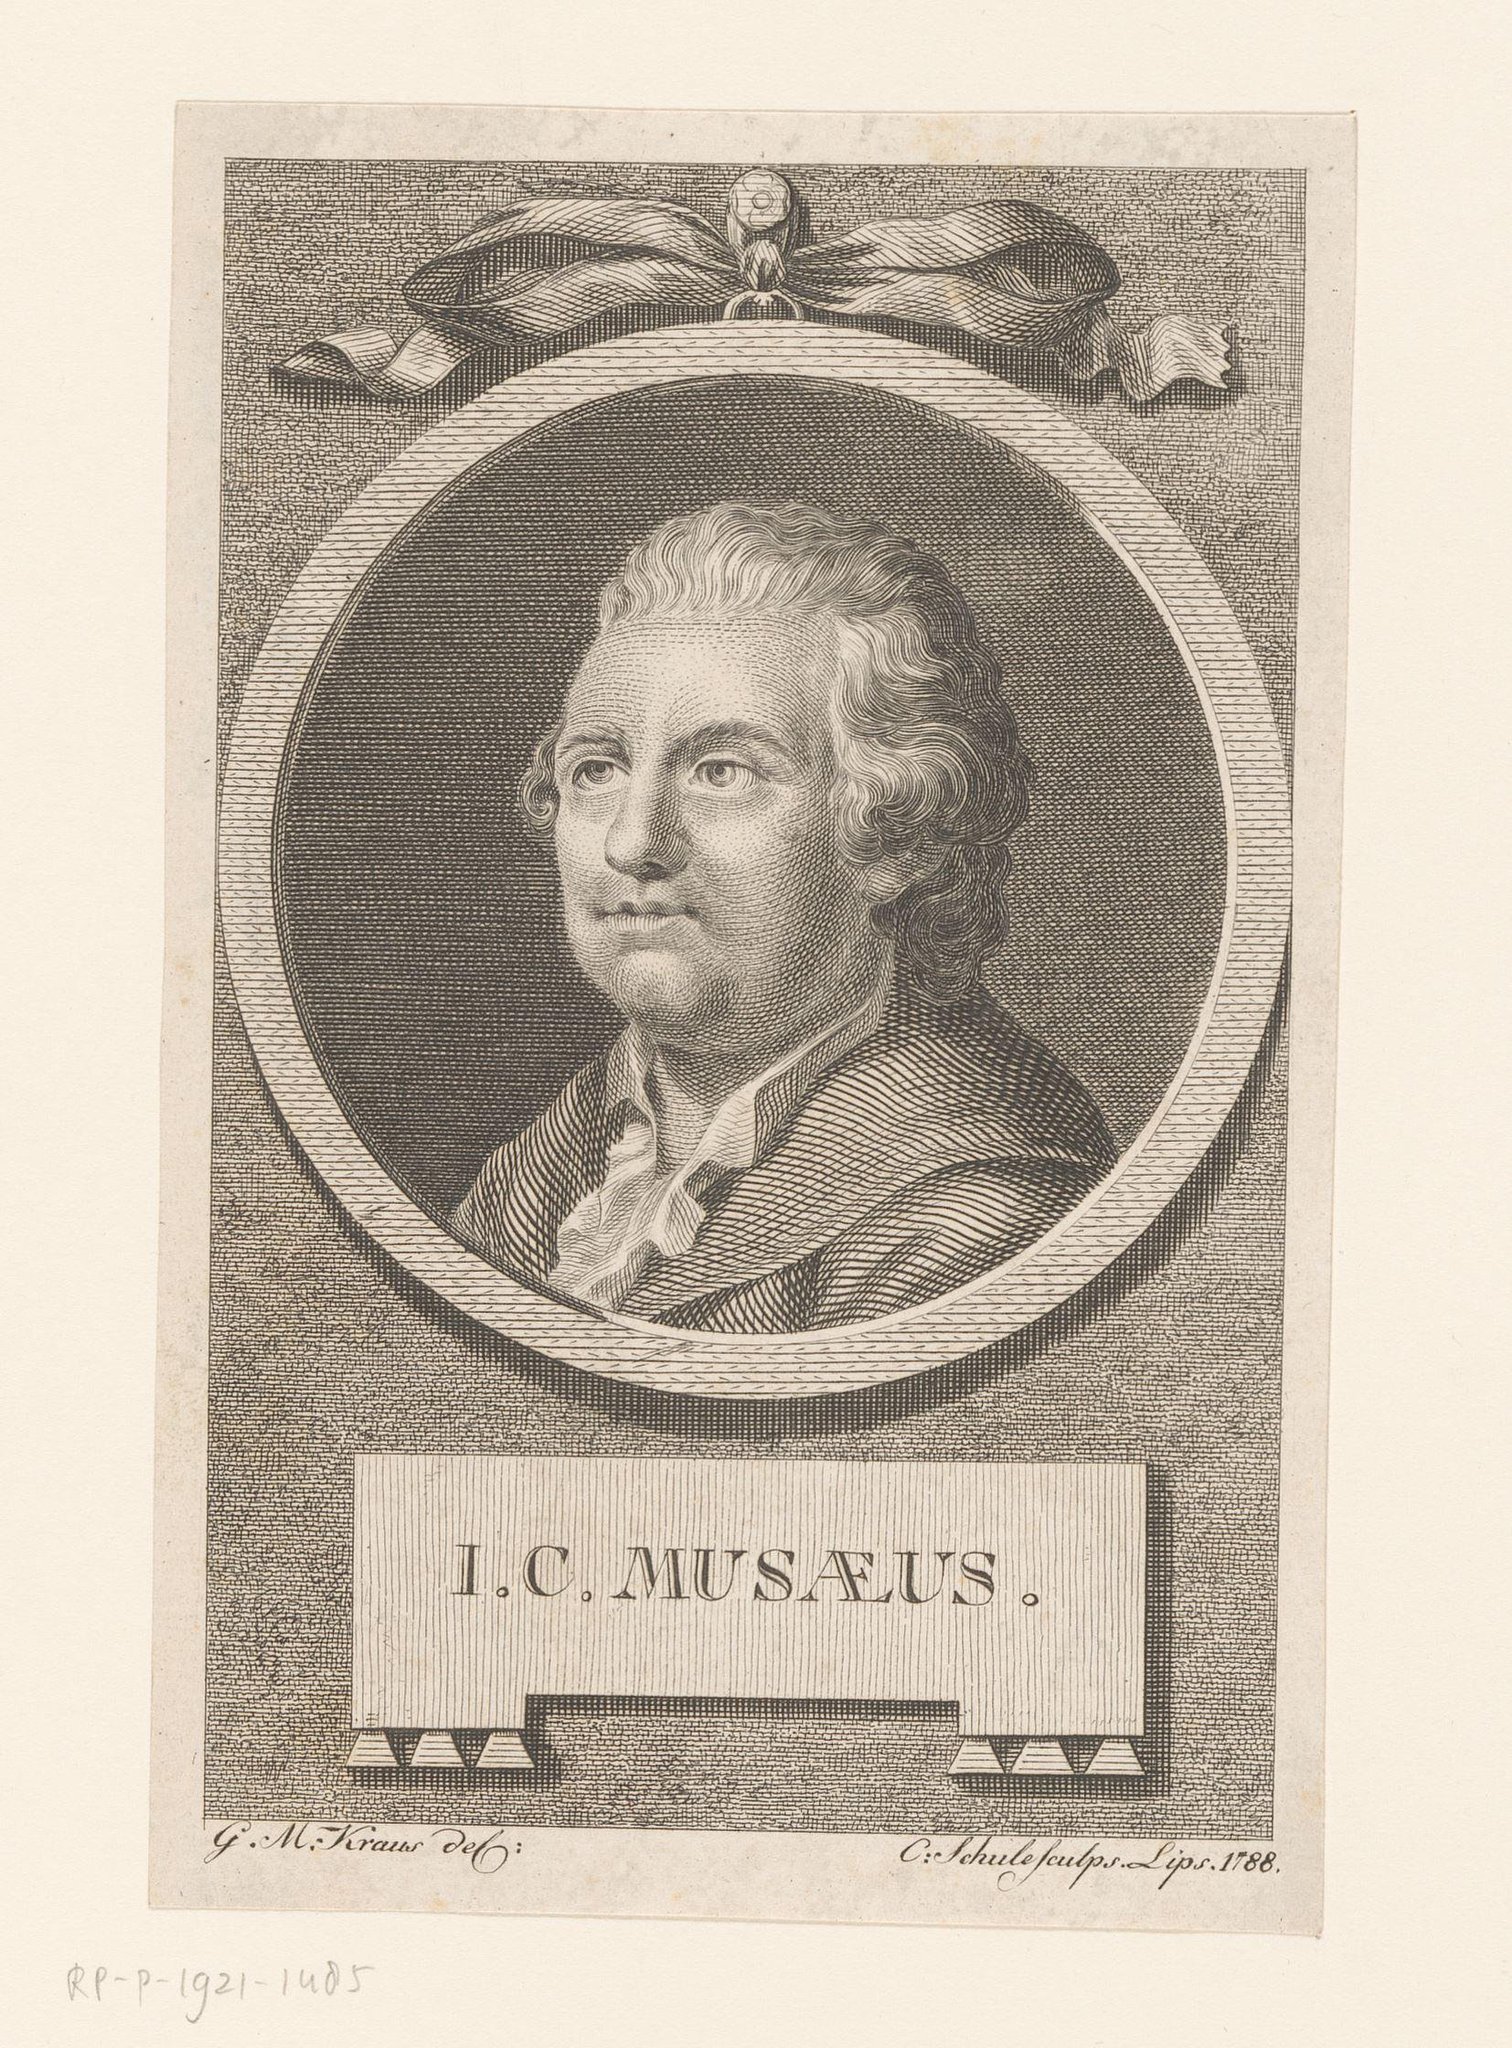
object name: print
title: J.C. Musaeus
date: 1788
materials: paper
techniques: engraving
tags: historical persons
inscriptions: collector's mark: Lugt 2233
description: Portret van Johann Karl August Musäus, Duits filoloog, schrijver en verzamelaar van Duitse volksverhalen.